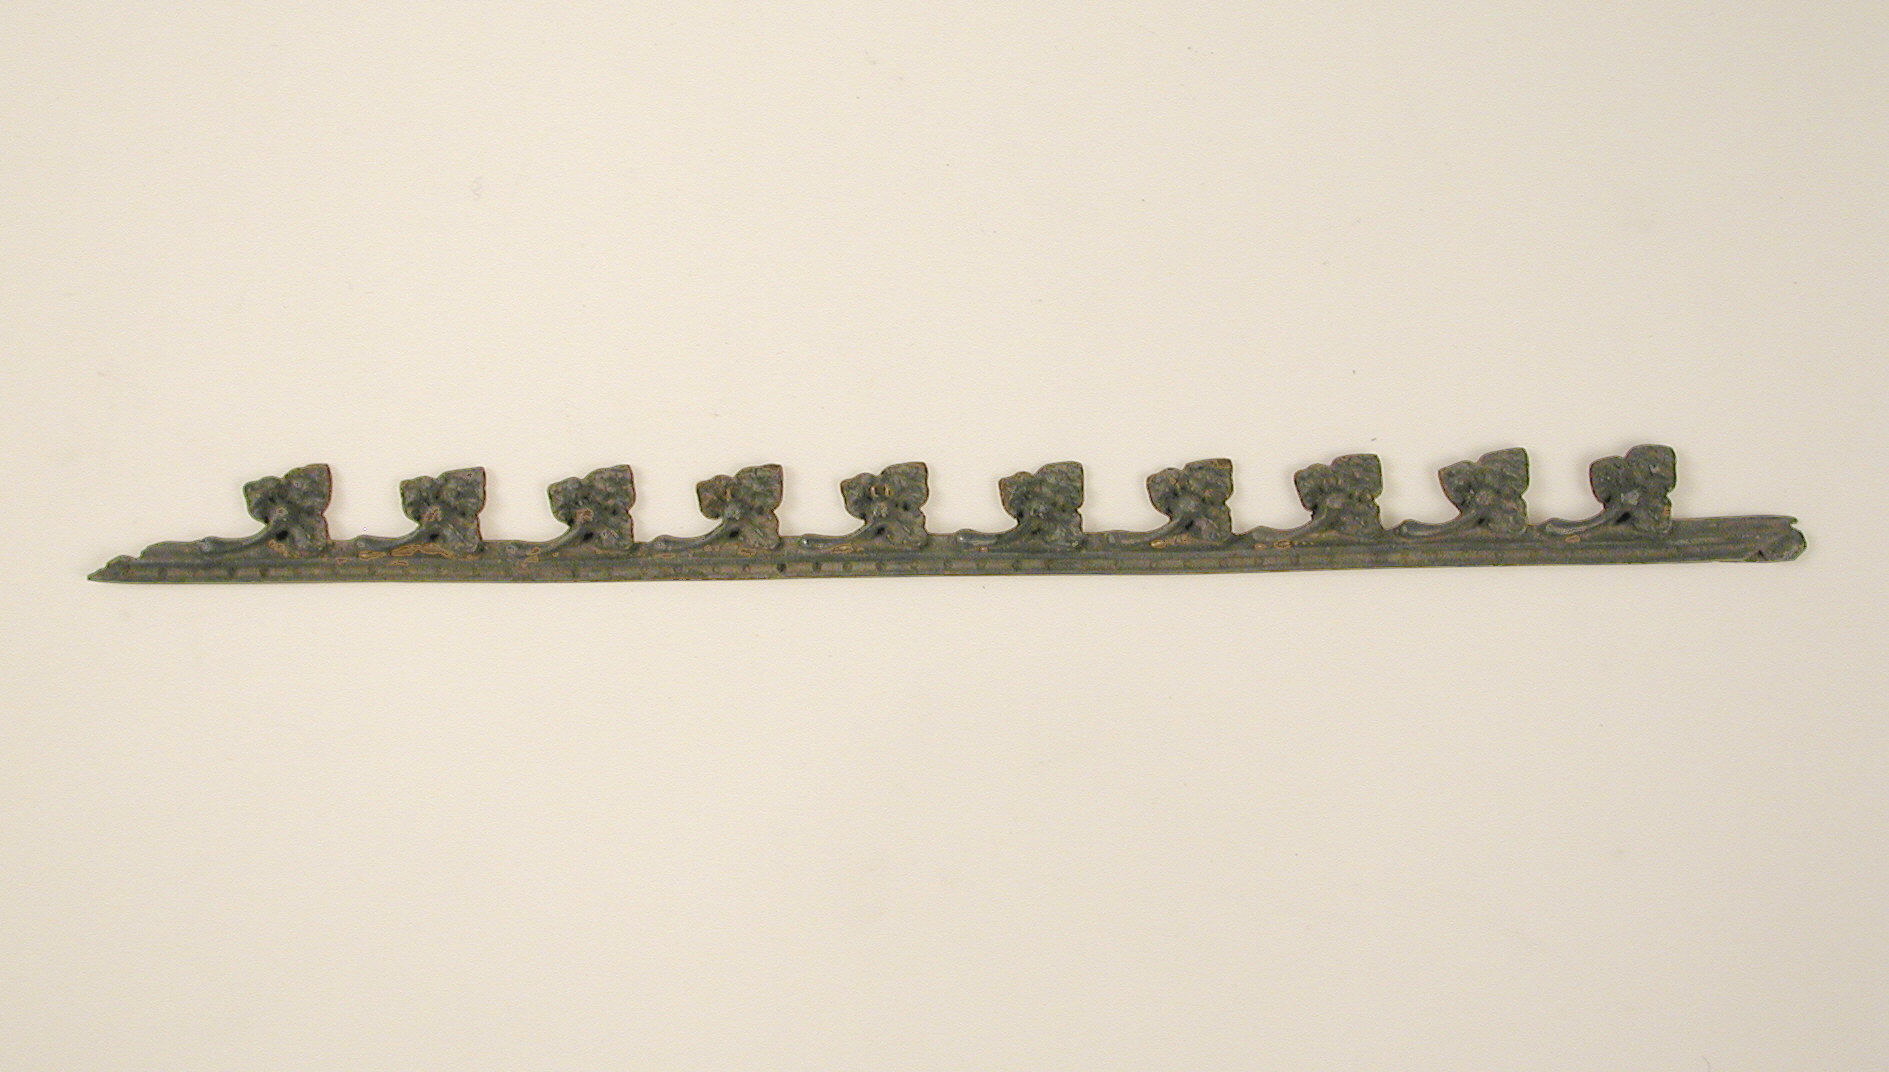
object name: miter band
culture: british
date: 1901-1933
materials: silver gilt